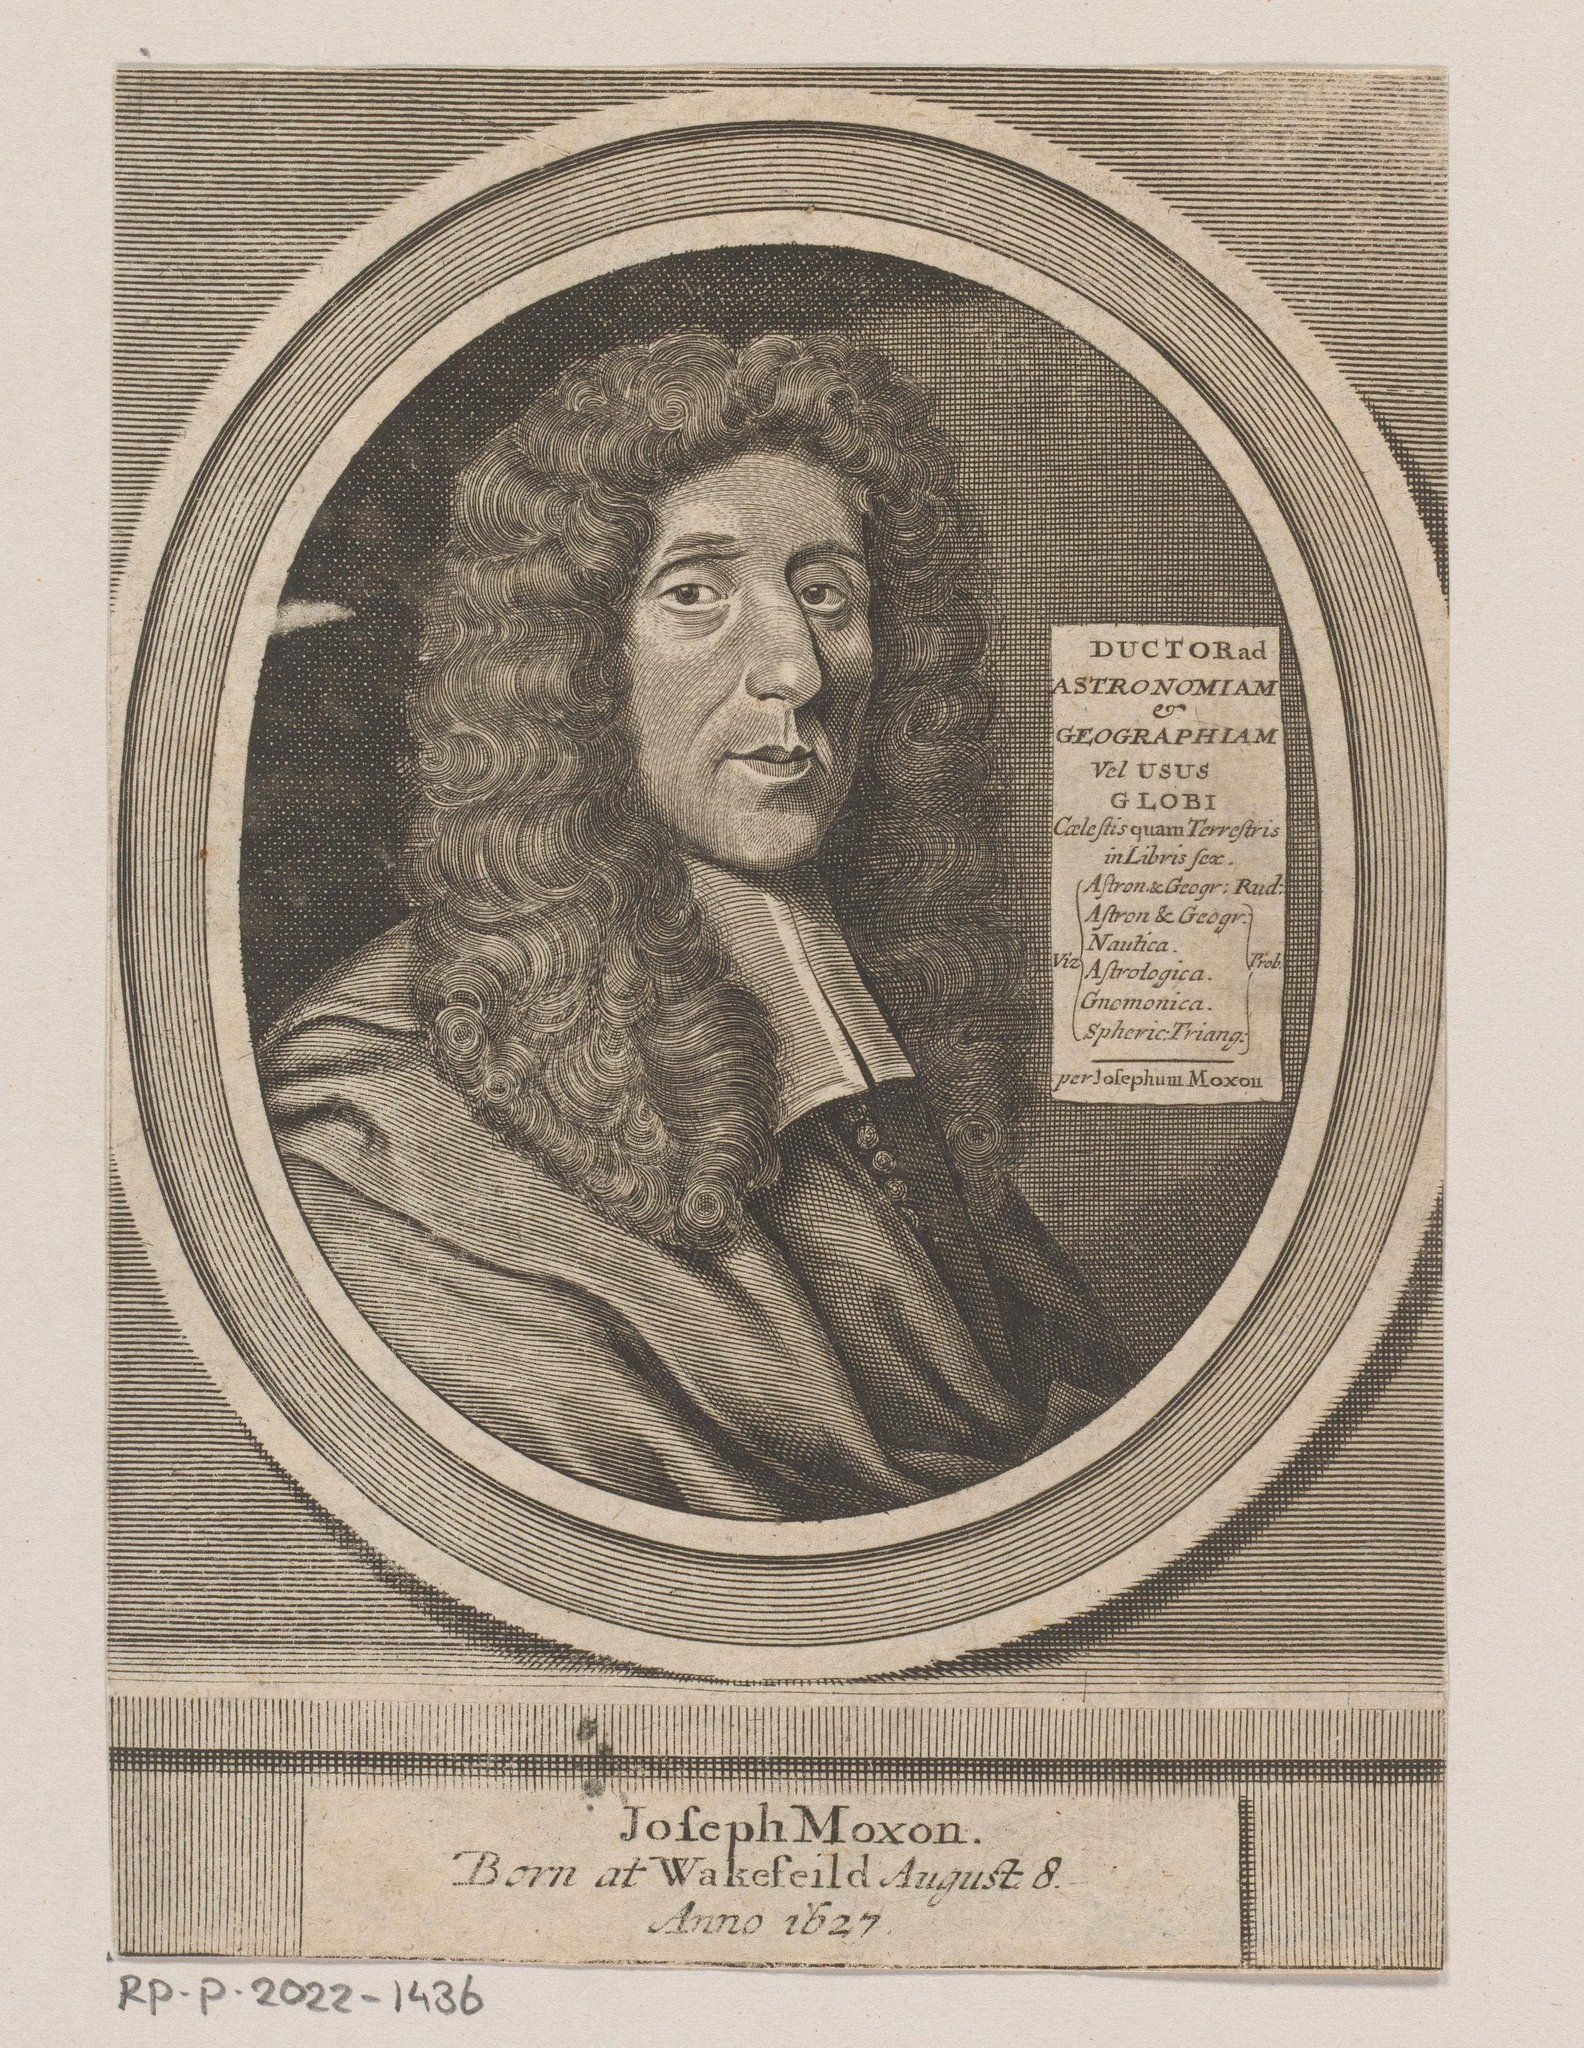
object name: book illustration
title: Joseph Moxon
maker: Anonymous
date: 1699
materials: paper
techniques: engraving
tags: historical persons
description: Prent waarschijnlijk uit: Moxon, Joseph. A Tutor to Astronomy and Geography. (...). Londen: Philip Lea, 1699.